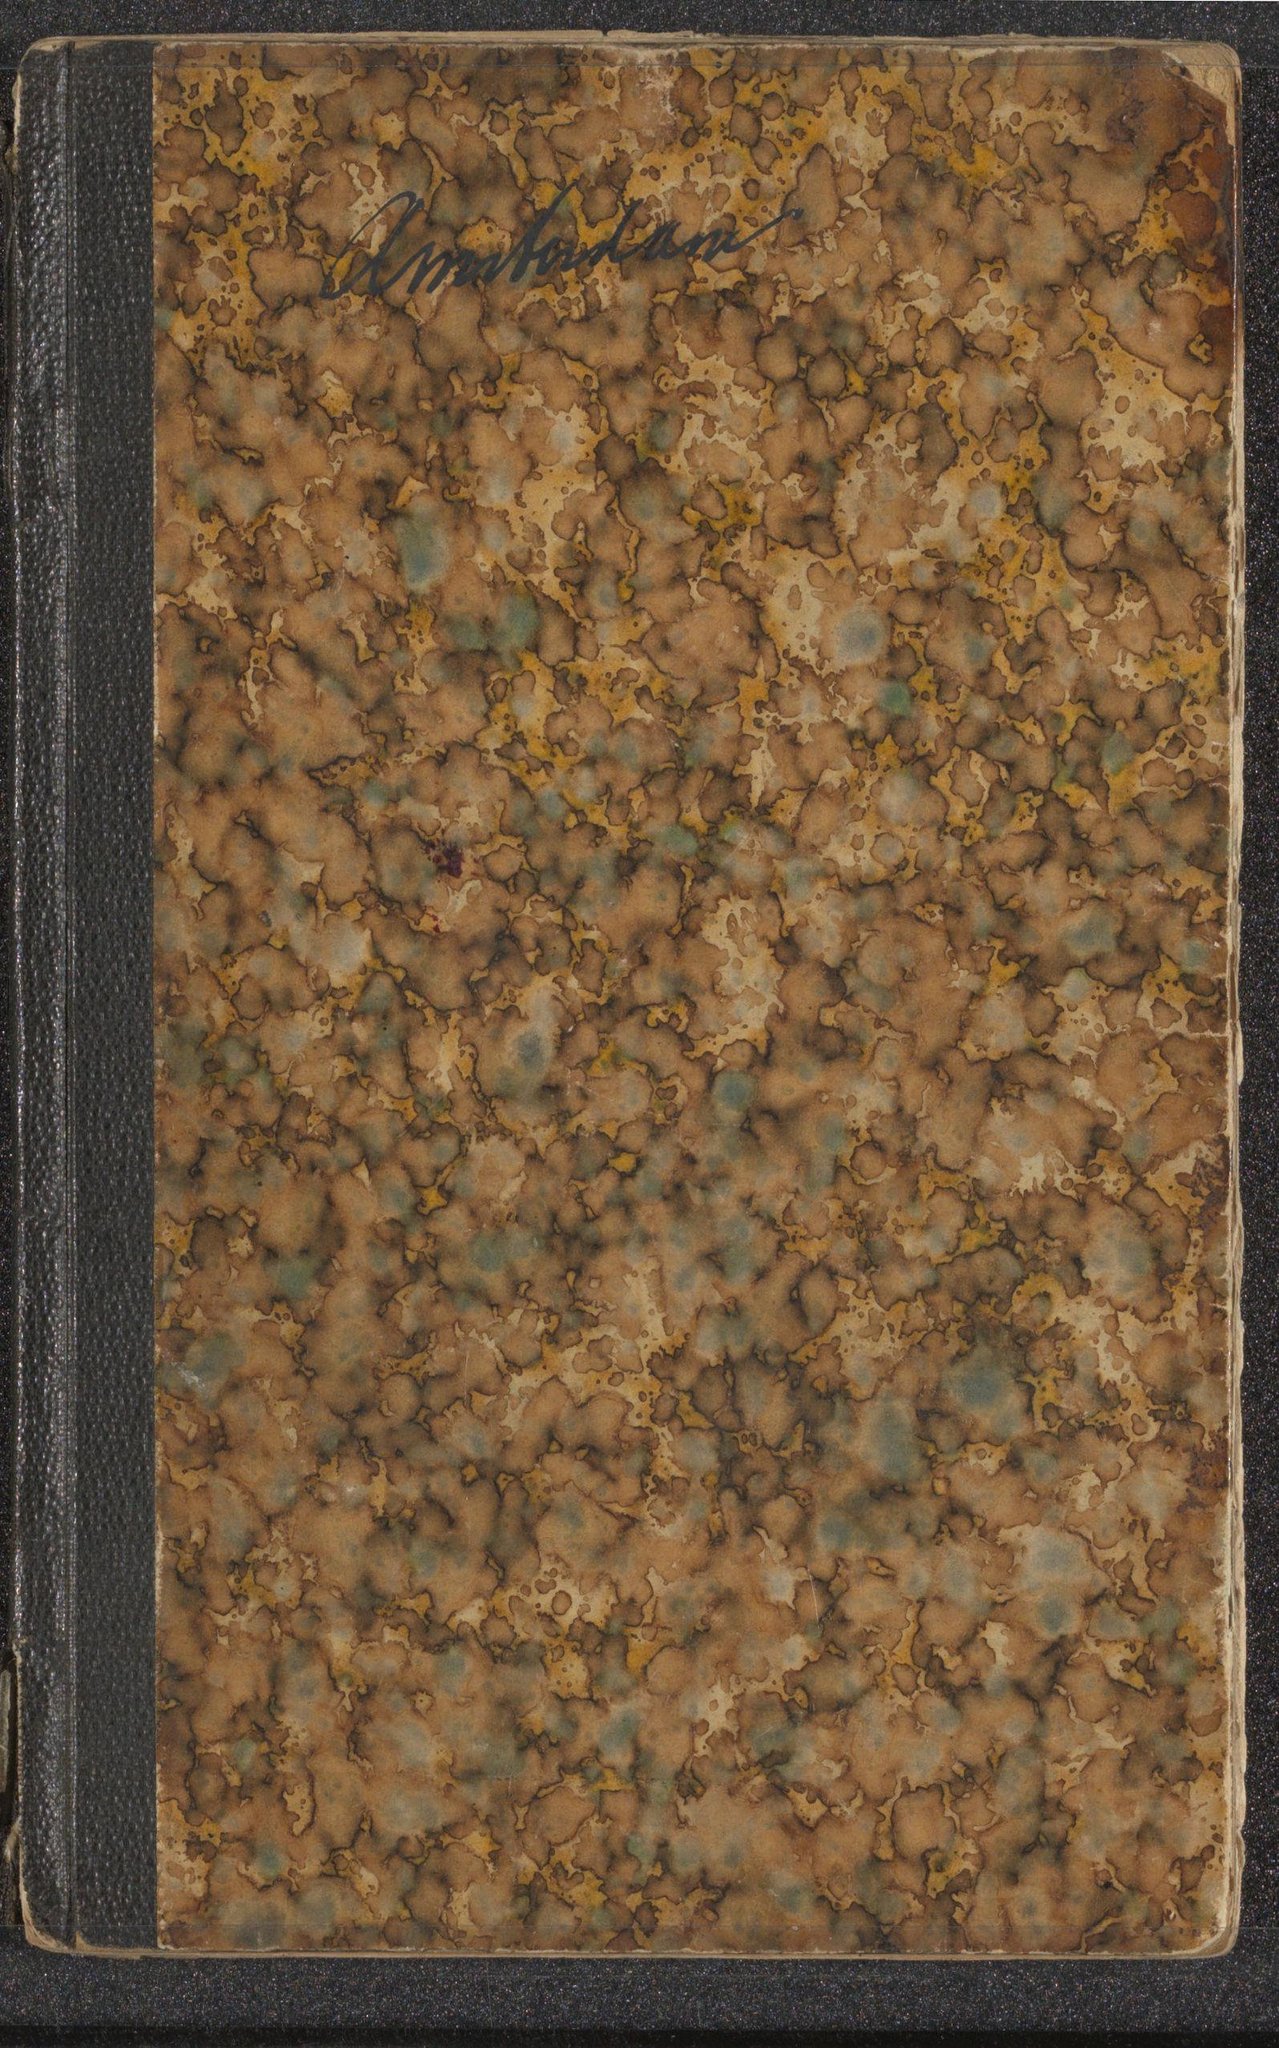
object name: sketchbook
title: Schetsboek met 17 bladen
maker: george hendrik breitner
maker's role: draughtsman, painter, print maker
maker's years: 1857-1923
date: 1887-1891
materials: cardboard, chalk, linen, paper, pencil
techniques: marbling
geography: amsterdam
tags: park, street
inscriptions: annotation: ‘Amsterdam’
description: Schetsboek bestaande uit 17 bladen met gezichten te Amsterdam.